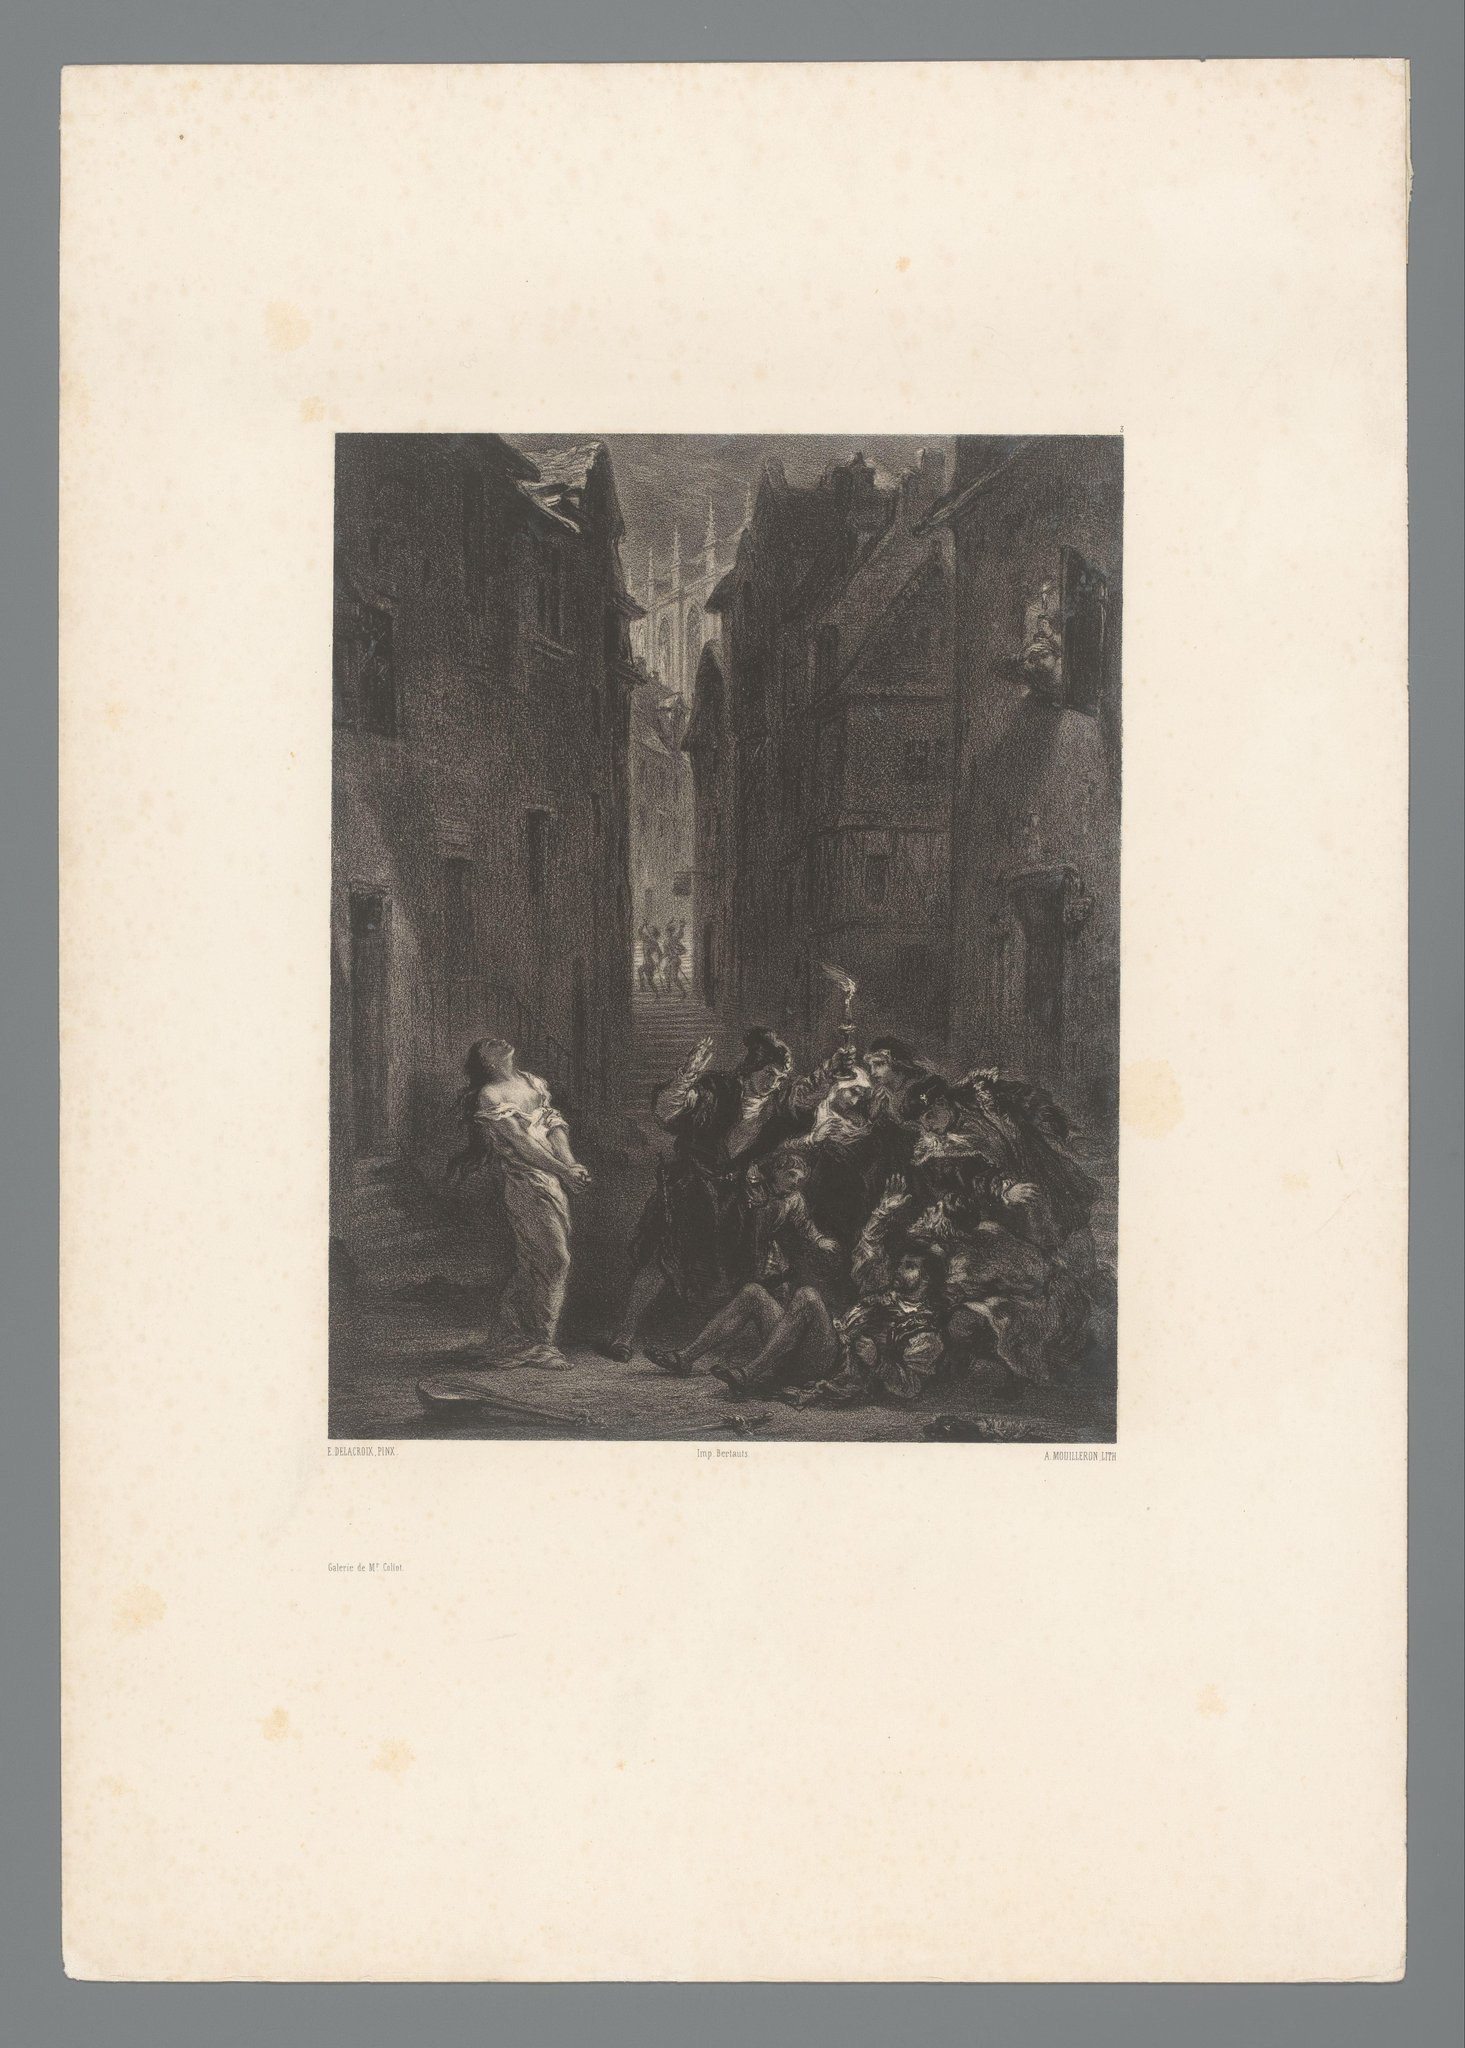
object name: print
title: La mort de Valentin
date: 1848-1862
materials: paper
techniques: lithograph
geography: paris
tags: murder, street, night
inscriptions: collector's mark: Lugt 964, check stamp: Lugt 36a, inscription: ‘Aug Allebé’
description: In een nauwe straat ligt rechts een man op de grond, omringd door zes personen, van wie er één een brandende kaars in de hand houdt. Links staat een vrouw met gevouwen handen in wanhopige houding.